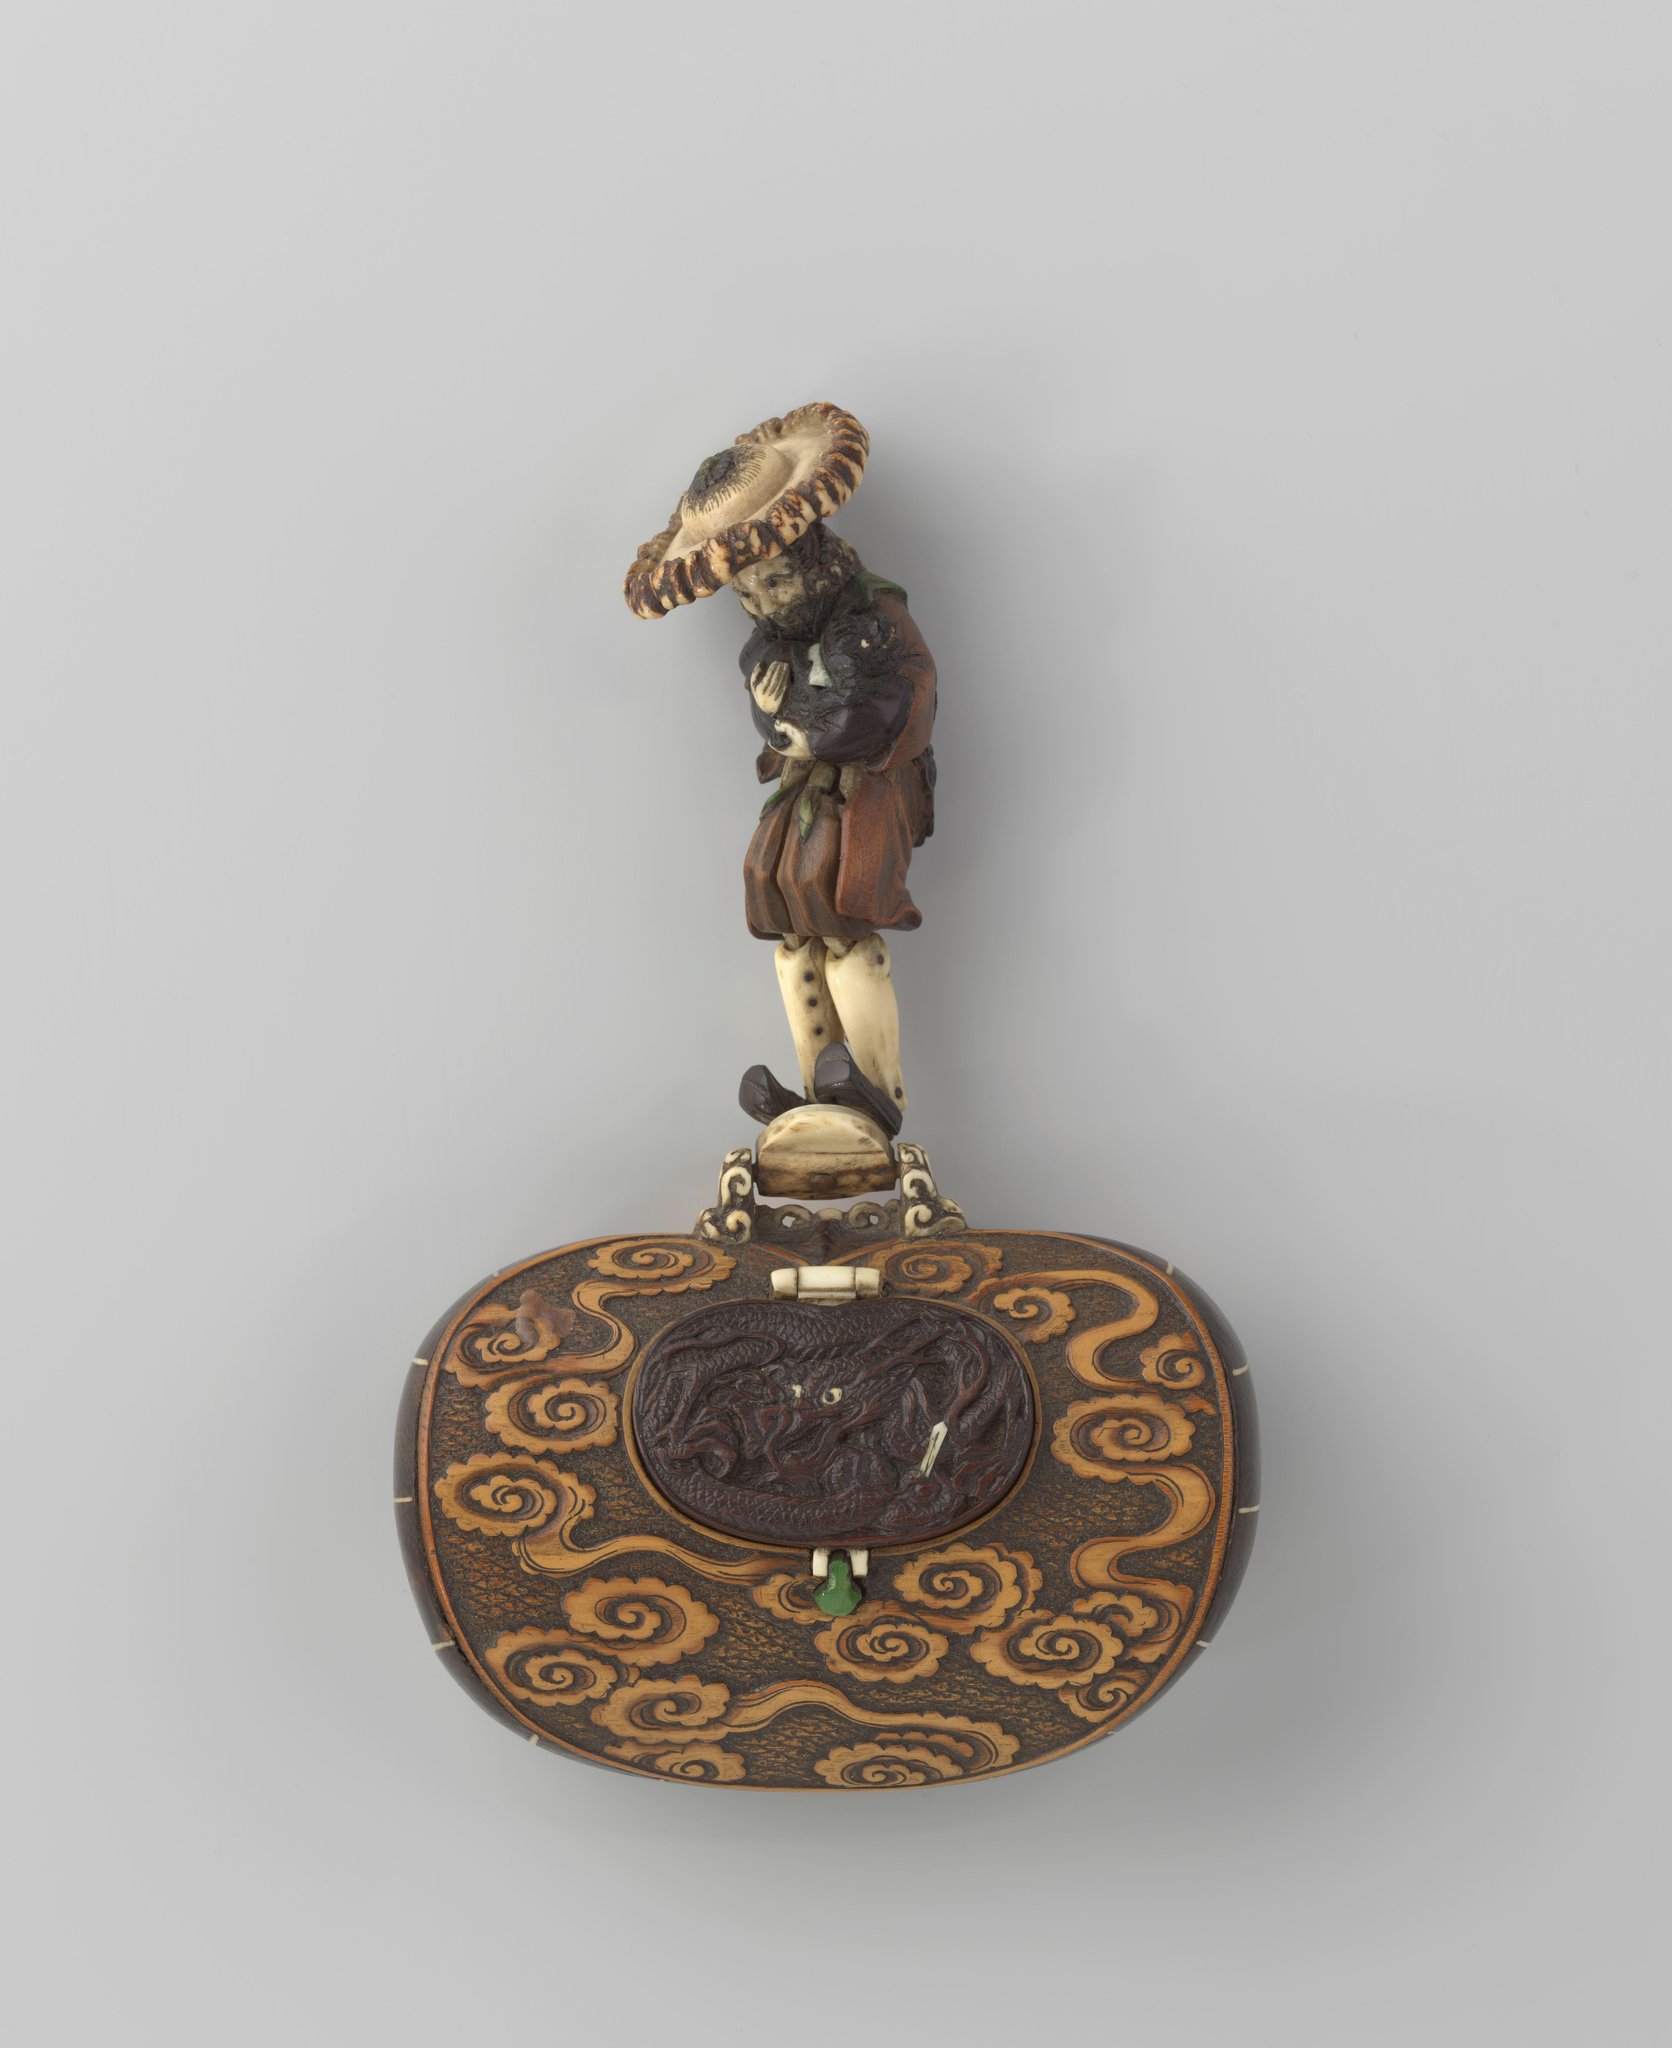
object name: rookgerei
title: Smoking Set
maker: ikko hasegawa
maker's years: 1800-1850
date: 1800-1850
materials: bamboo, bone, ivory, wood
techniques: carving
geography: japan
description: This smoking set was worn at the waist, suspended from a belt. The tobacco container is made of carved bamboo inlaid with a tiger motif. The Dutchman, on top, served as a toggle (netsuke) and when worn was concealed behind the belt. Only his hat would protrude from it, keeping the set from slipping down. The man with a dog in his arms makes a somewhat comical impression.